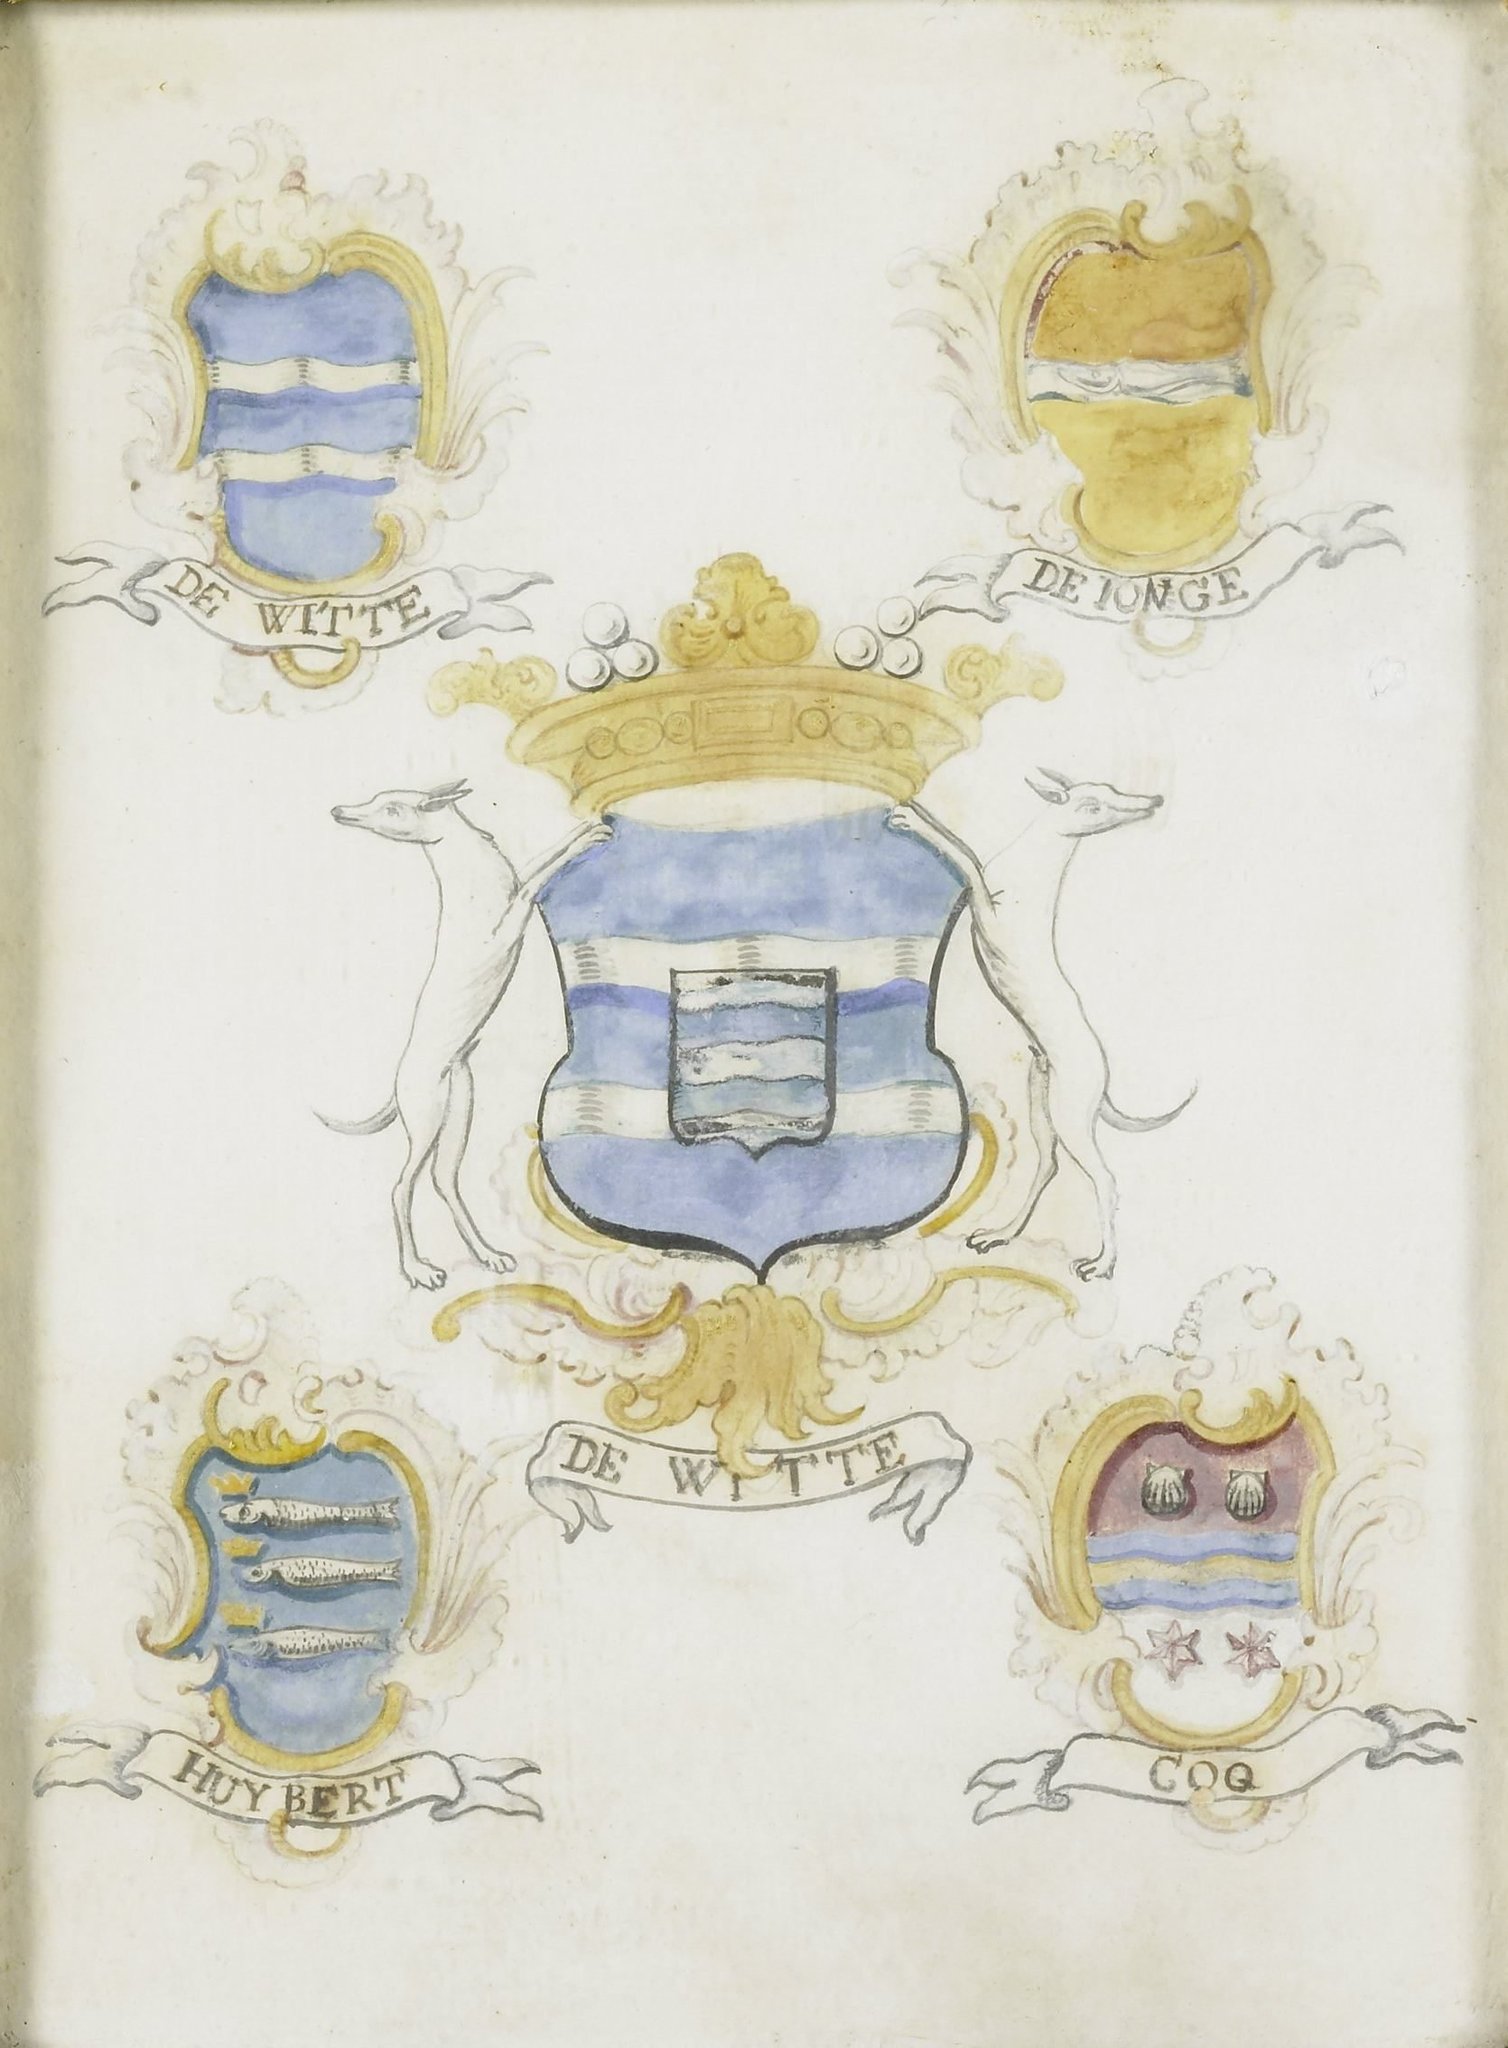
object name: family arm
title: Het wapen van Jacob de Witte, vader van Laurens Jacobsz de Witte, met de wapens van zijn vier grootouders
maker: Anonymous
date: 1750-1799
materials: paper, watercolor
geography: northern netherlands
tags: armorial bearing, heraldry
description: Het wapen van Jacob de Witte, vader van Laurens Jacobsz de Witte, met de wapens van zijn vier grootouders: de Witte, [de] Huybert, de Jonge en [de] Coq. Onderdeel van een reeks wapens behorend bij de schenking Jonkheer J. de Witte van Citters, Den Haag, 1876. Onderdeel van de collectie heraldische objecten.